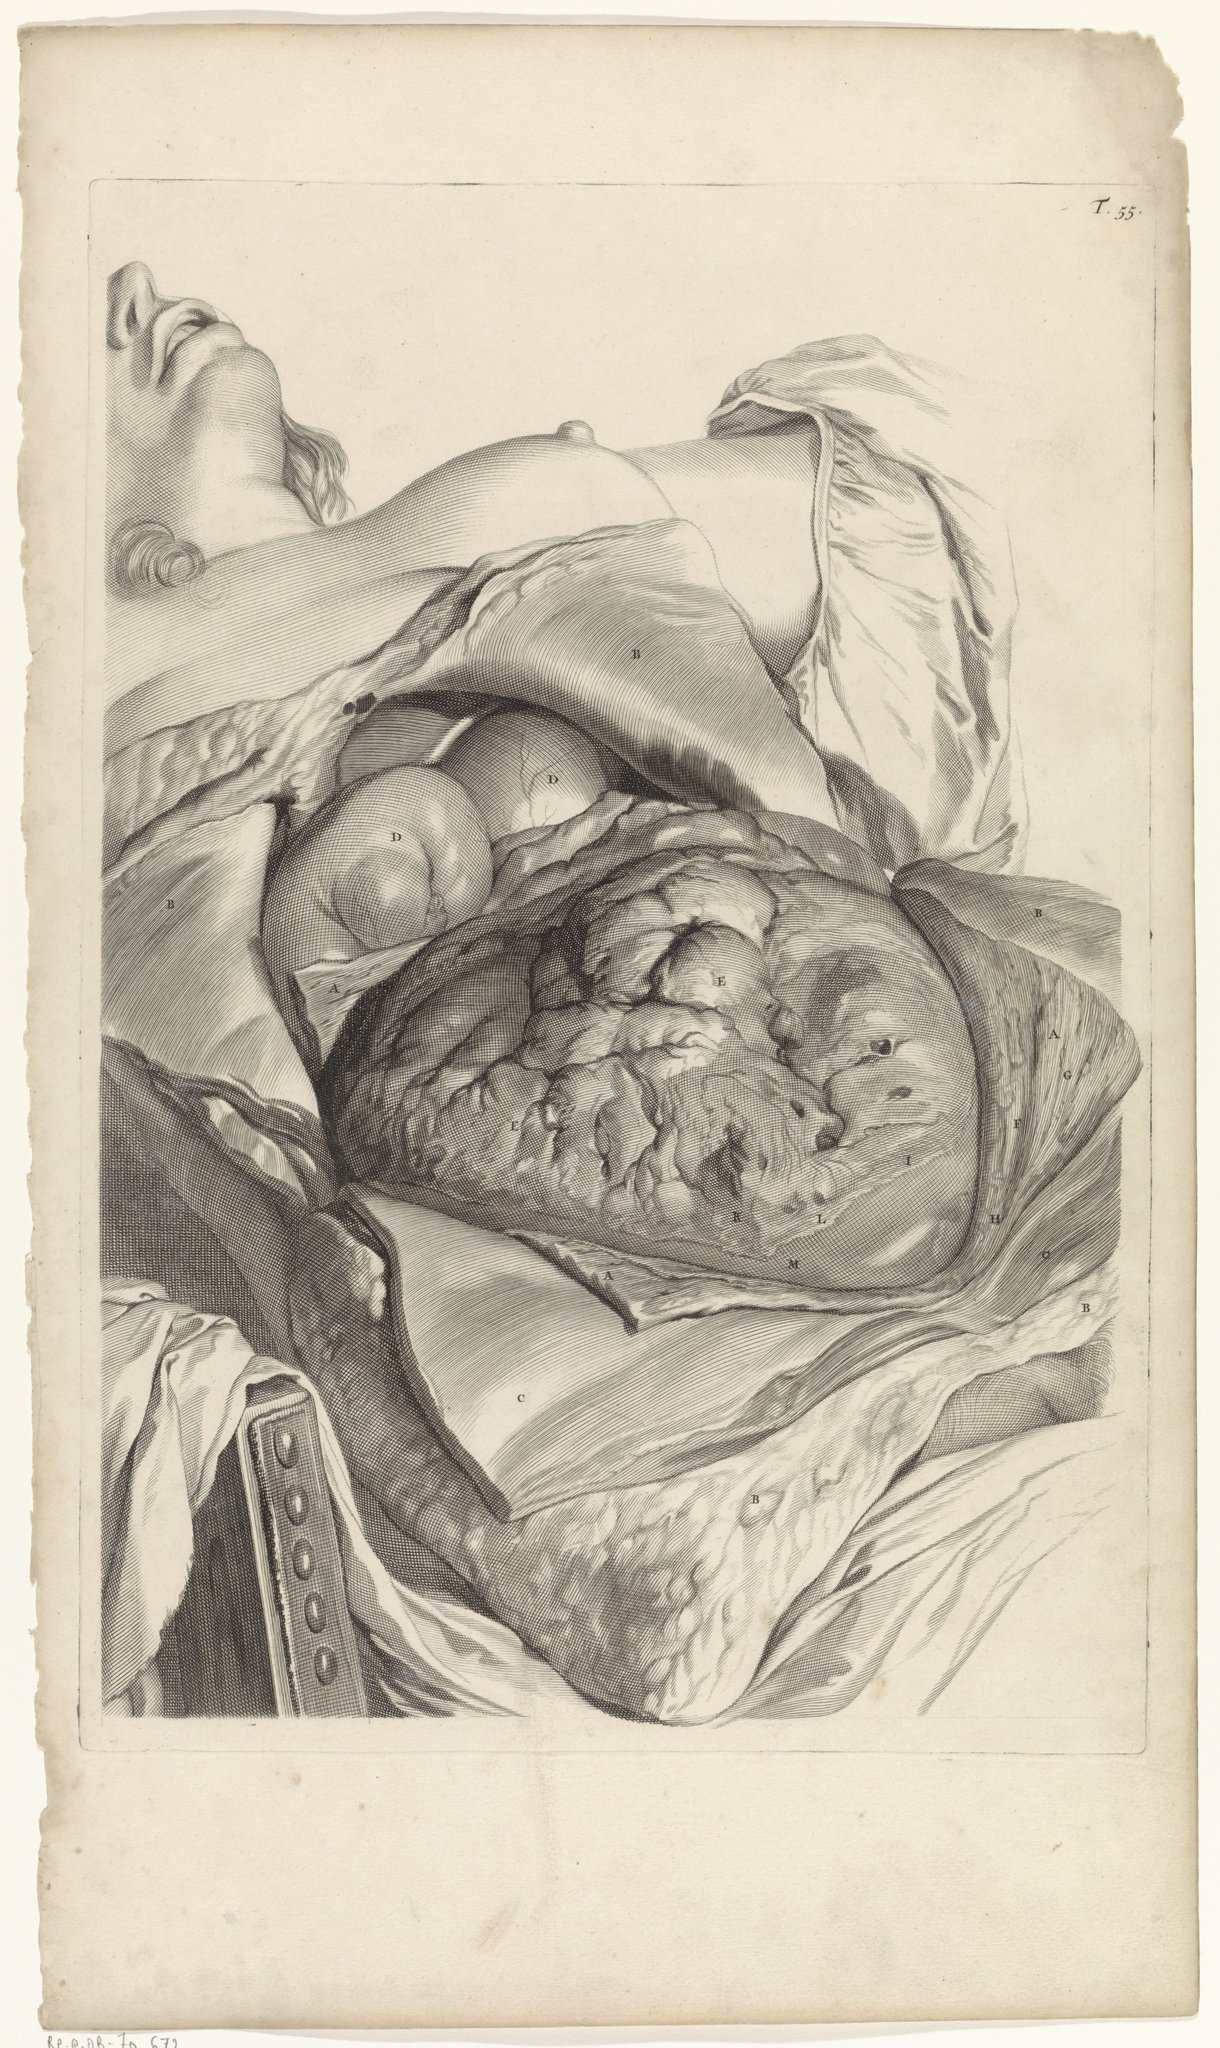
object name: print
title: Anatomische studie van de buitenkant van de baarmoeder van een zwangere vrouw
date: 1685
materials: paper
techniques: engraving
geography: amsterdam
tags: uterus with foetus, pregnant woman, pregnancy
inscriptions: collector's mark: Lugt 2228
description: Boekillustratie voor Bidloo, Godefridus. Anatomia humani corporis centum & quinque tabulis, per art. G. de Lairesse ad vivum delineatis, de monstrata, veterum recentiorumque inventis explicata plurimisque, hactenus non detectis, illustrata. Amsterdam: Weduwe Joannes van Someren, Hendrick Boom en erven Dirk Boom, 1685.